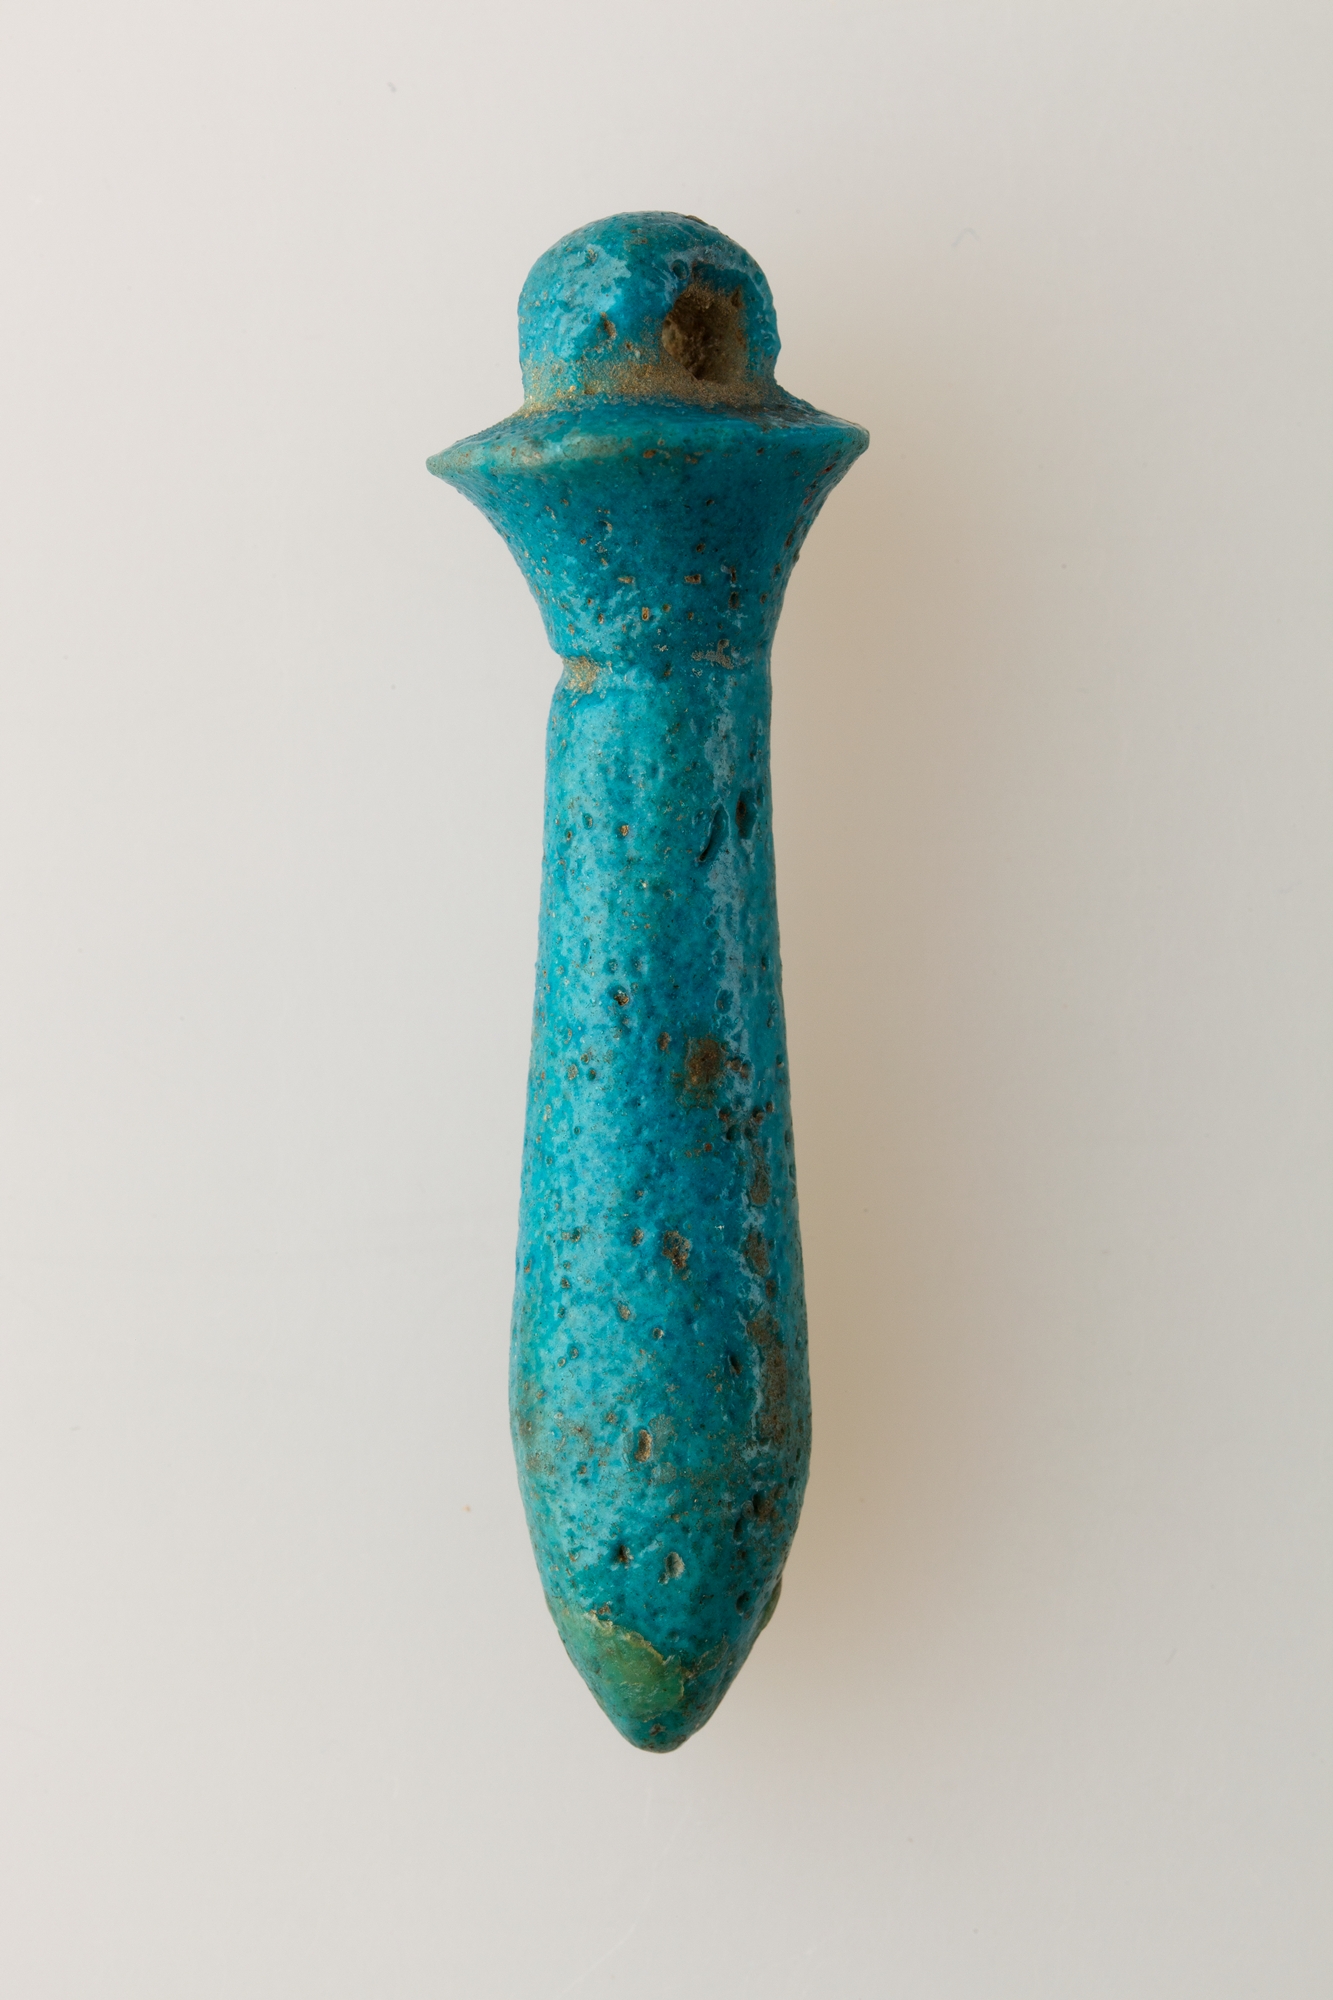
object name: amulet, papyrus column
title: Papyrus column amulet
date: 664-630 BCE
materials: faience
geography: egypt